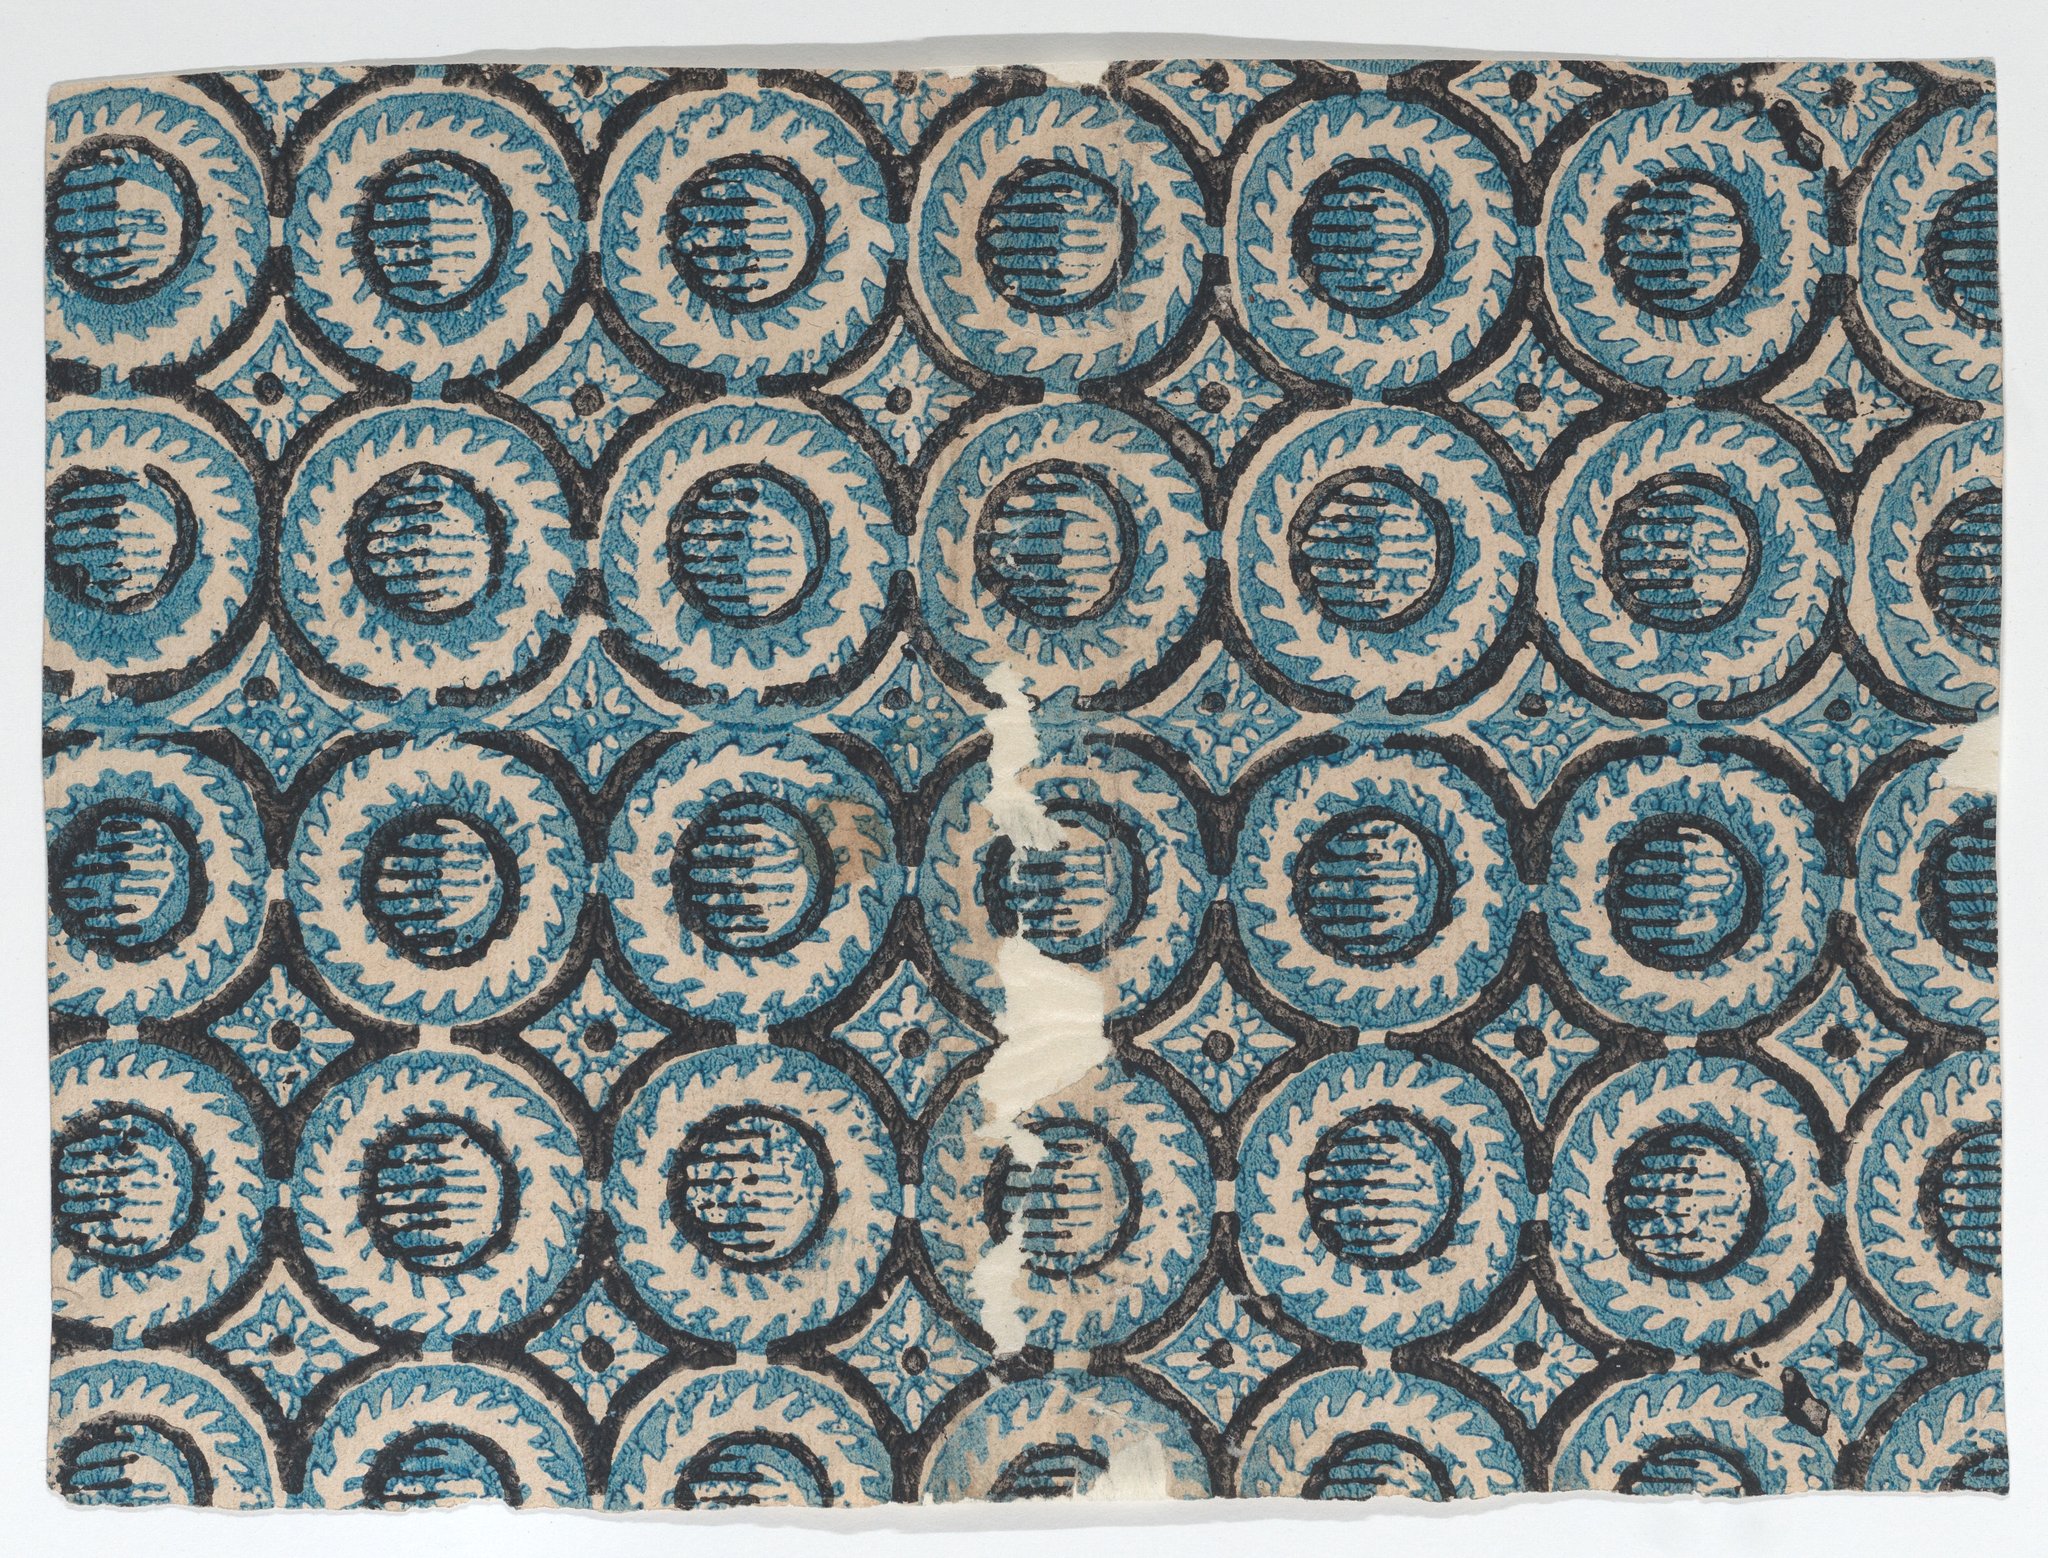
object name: print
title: Sheet with overall blue circular pattern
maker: Anonymous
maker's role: artist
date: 1701-1800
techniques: relief print